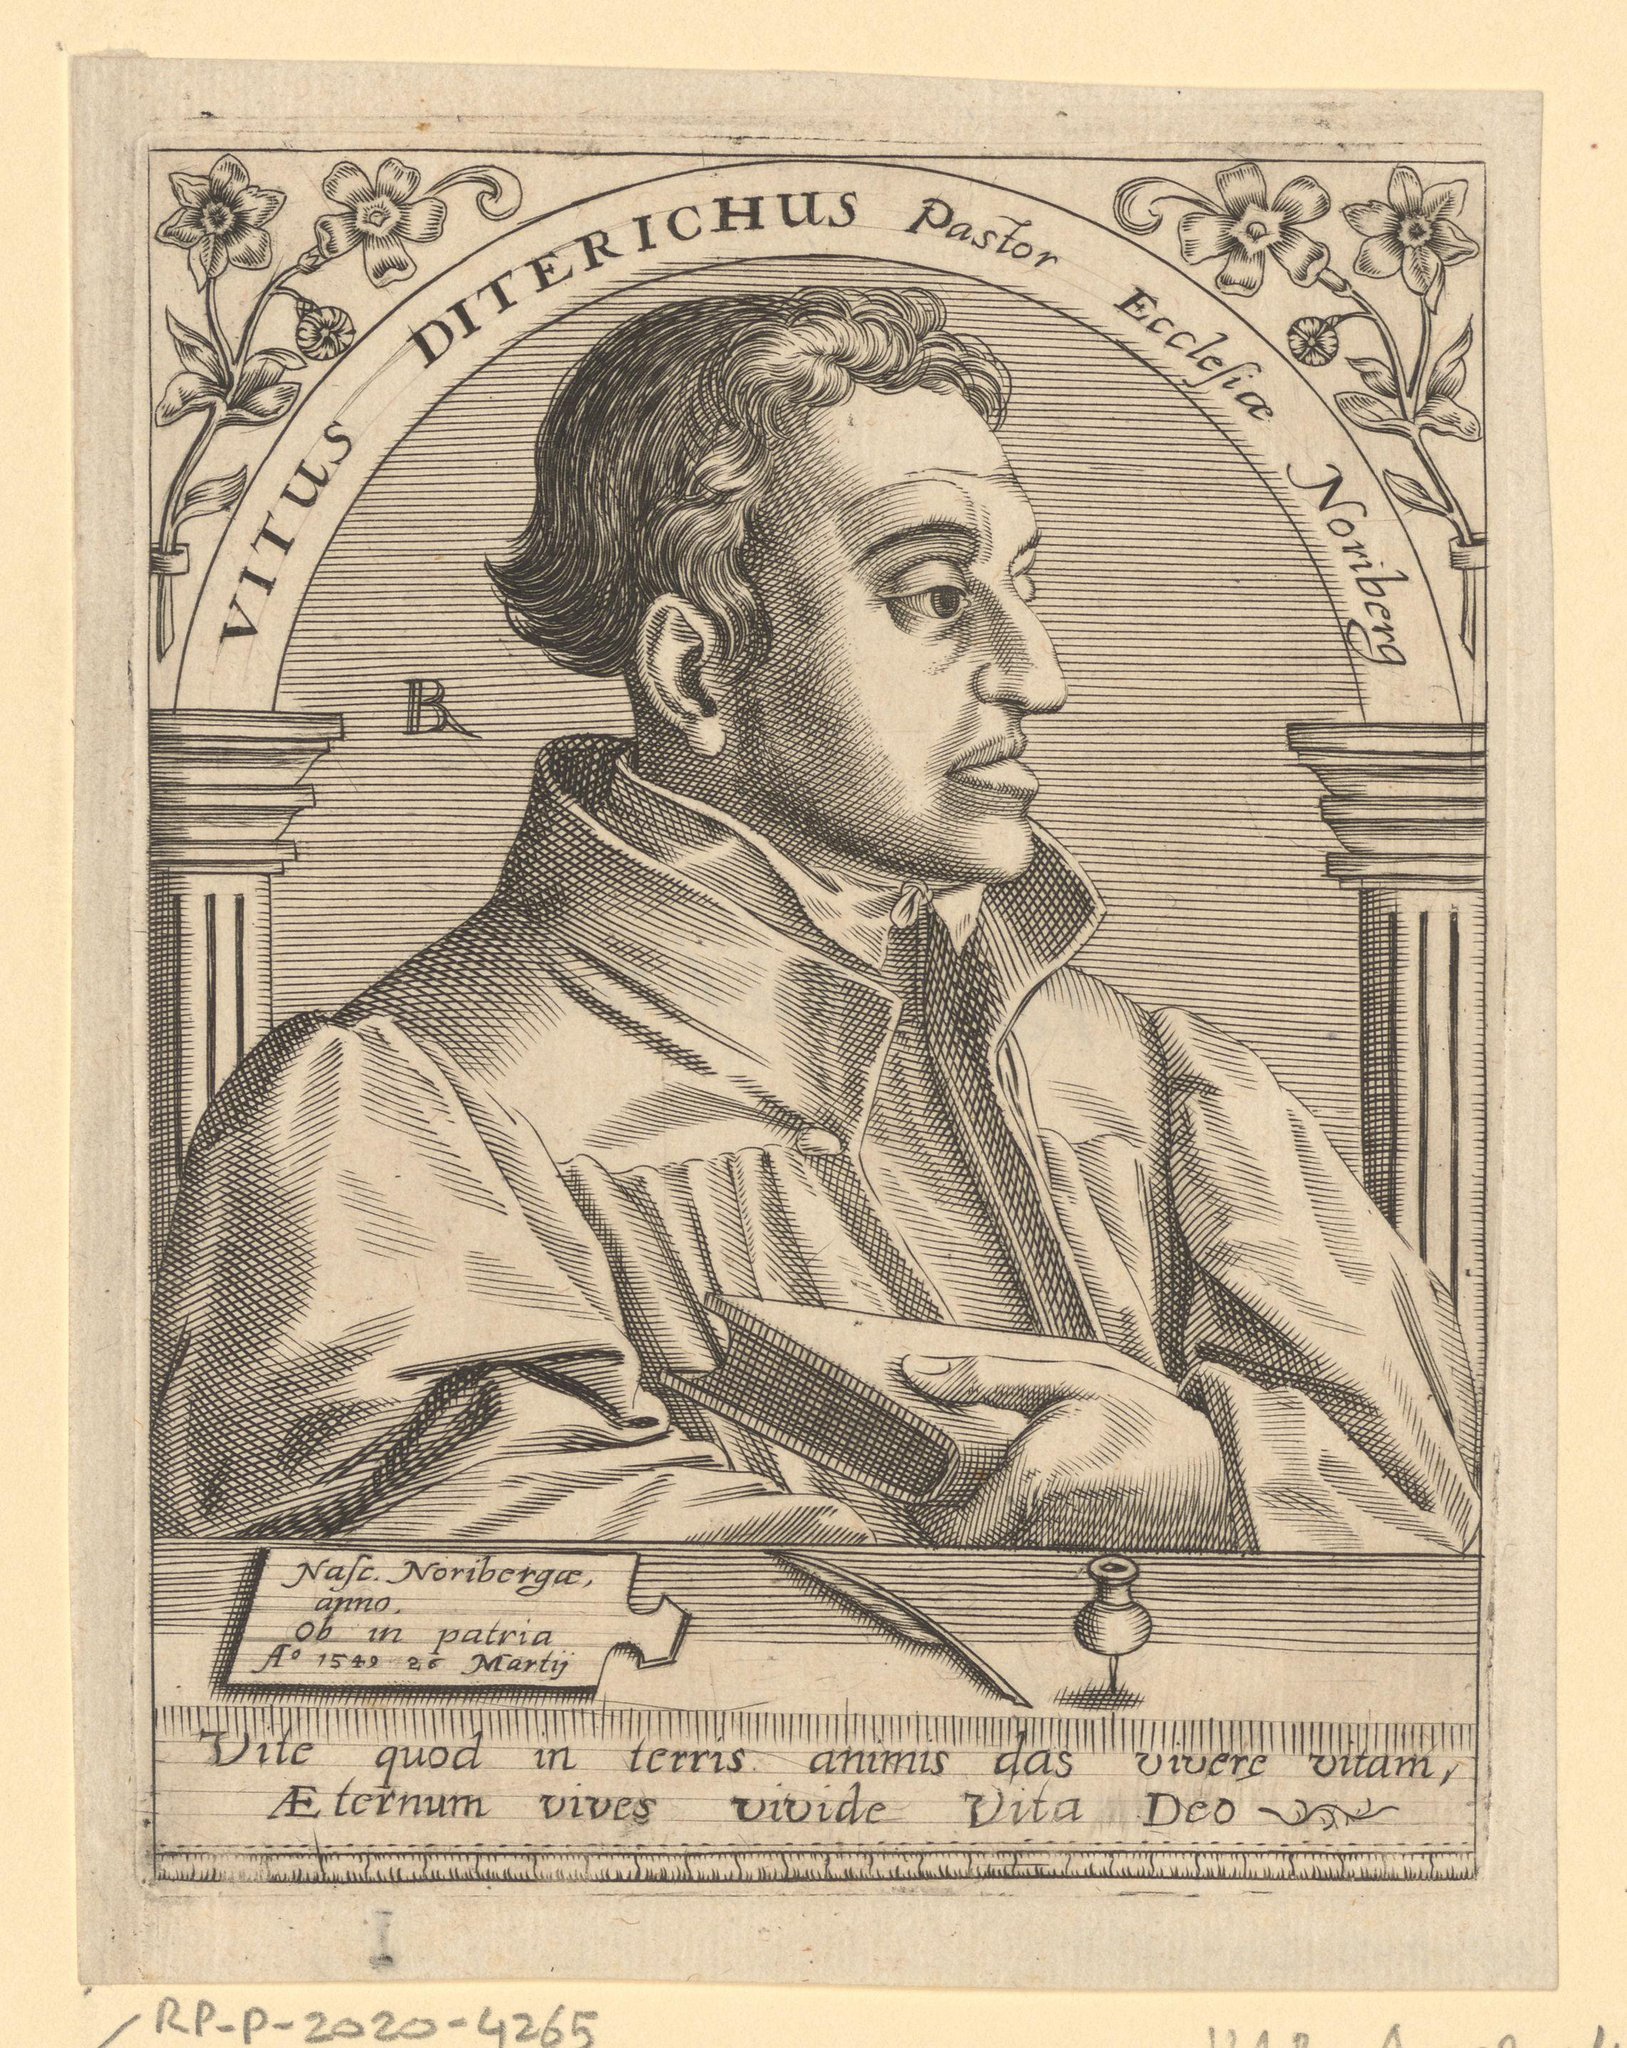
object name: print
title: Portret van Veit Dietrich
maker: robert boissard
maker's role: print maker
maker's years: 1570-1611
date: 1597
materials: paper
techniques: engraving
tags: theologian, historical persons, book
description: Prent mogelijk uit: Boissard, Jean Jacques. Icones quinquaginta virorum illustrium doctrina & eruditione praestantium ad vivum effictae. Frankfurt am Main: s.n., 1597. Prent met nummering rechtsonder gebruikt in: Bibliotheca chalcographica. Frankfurt am Main: Johannes Ammon, 1650.